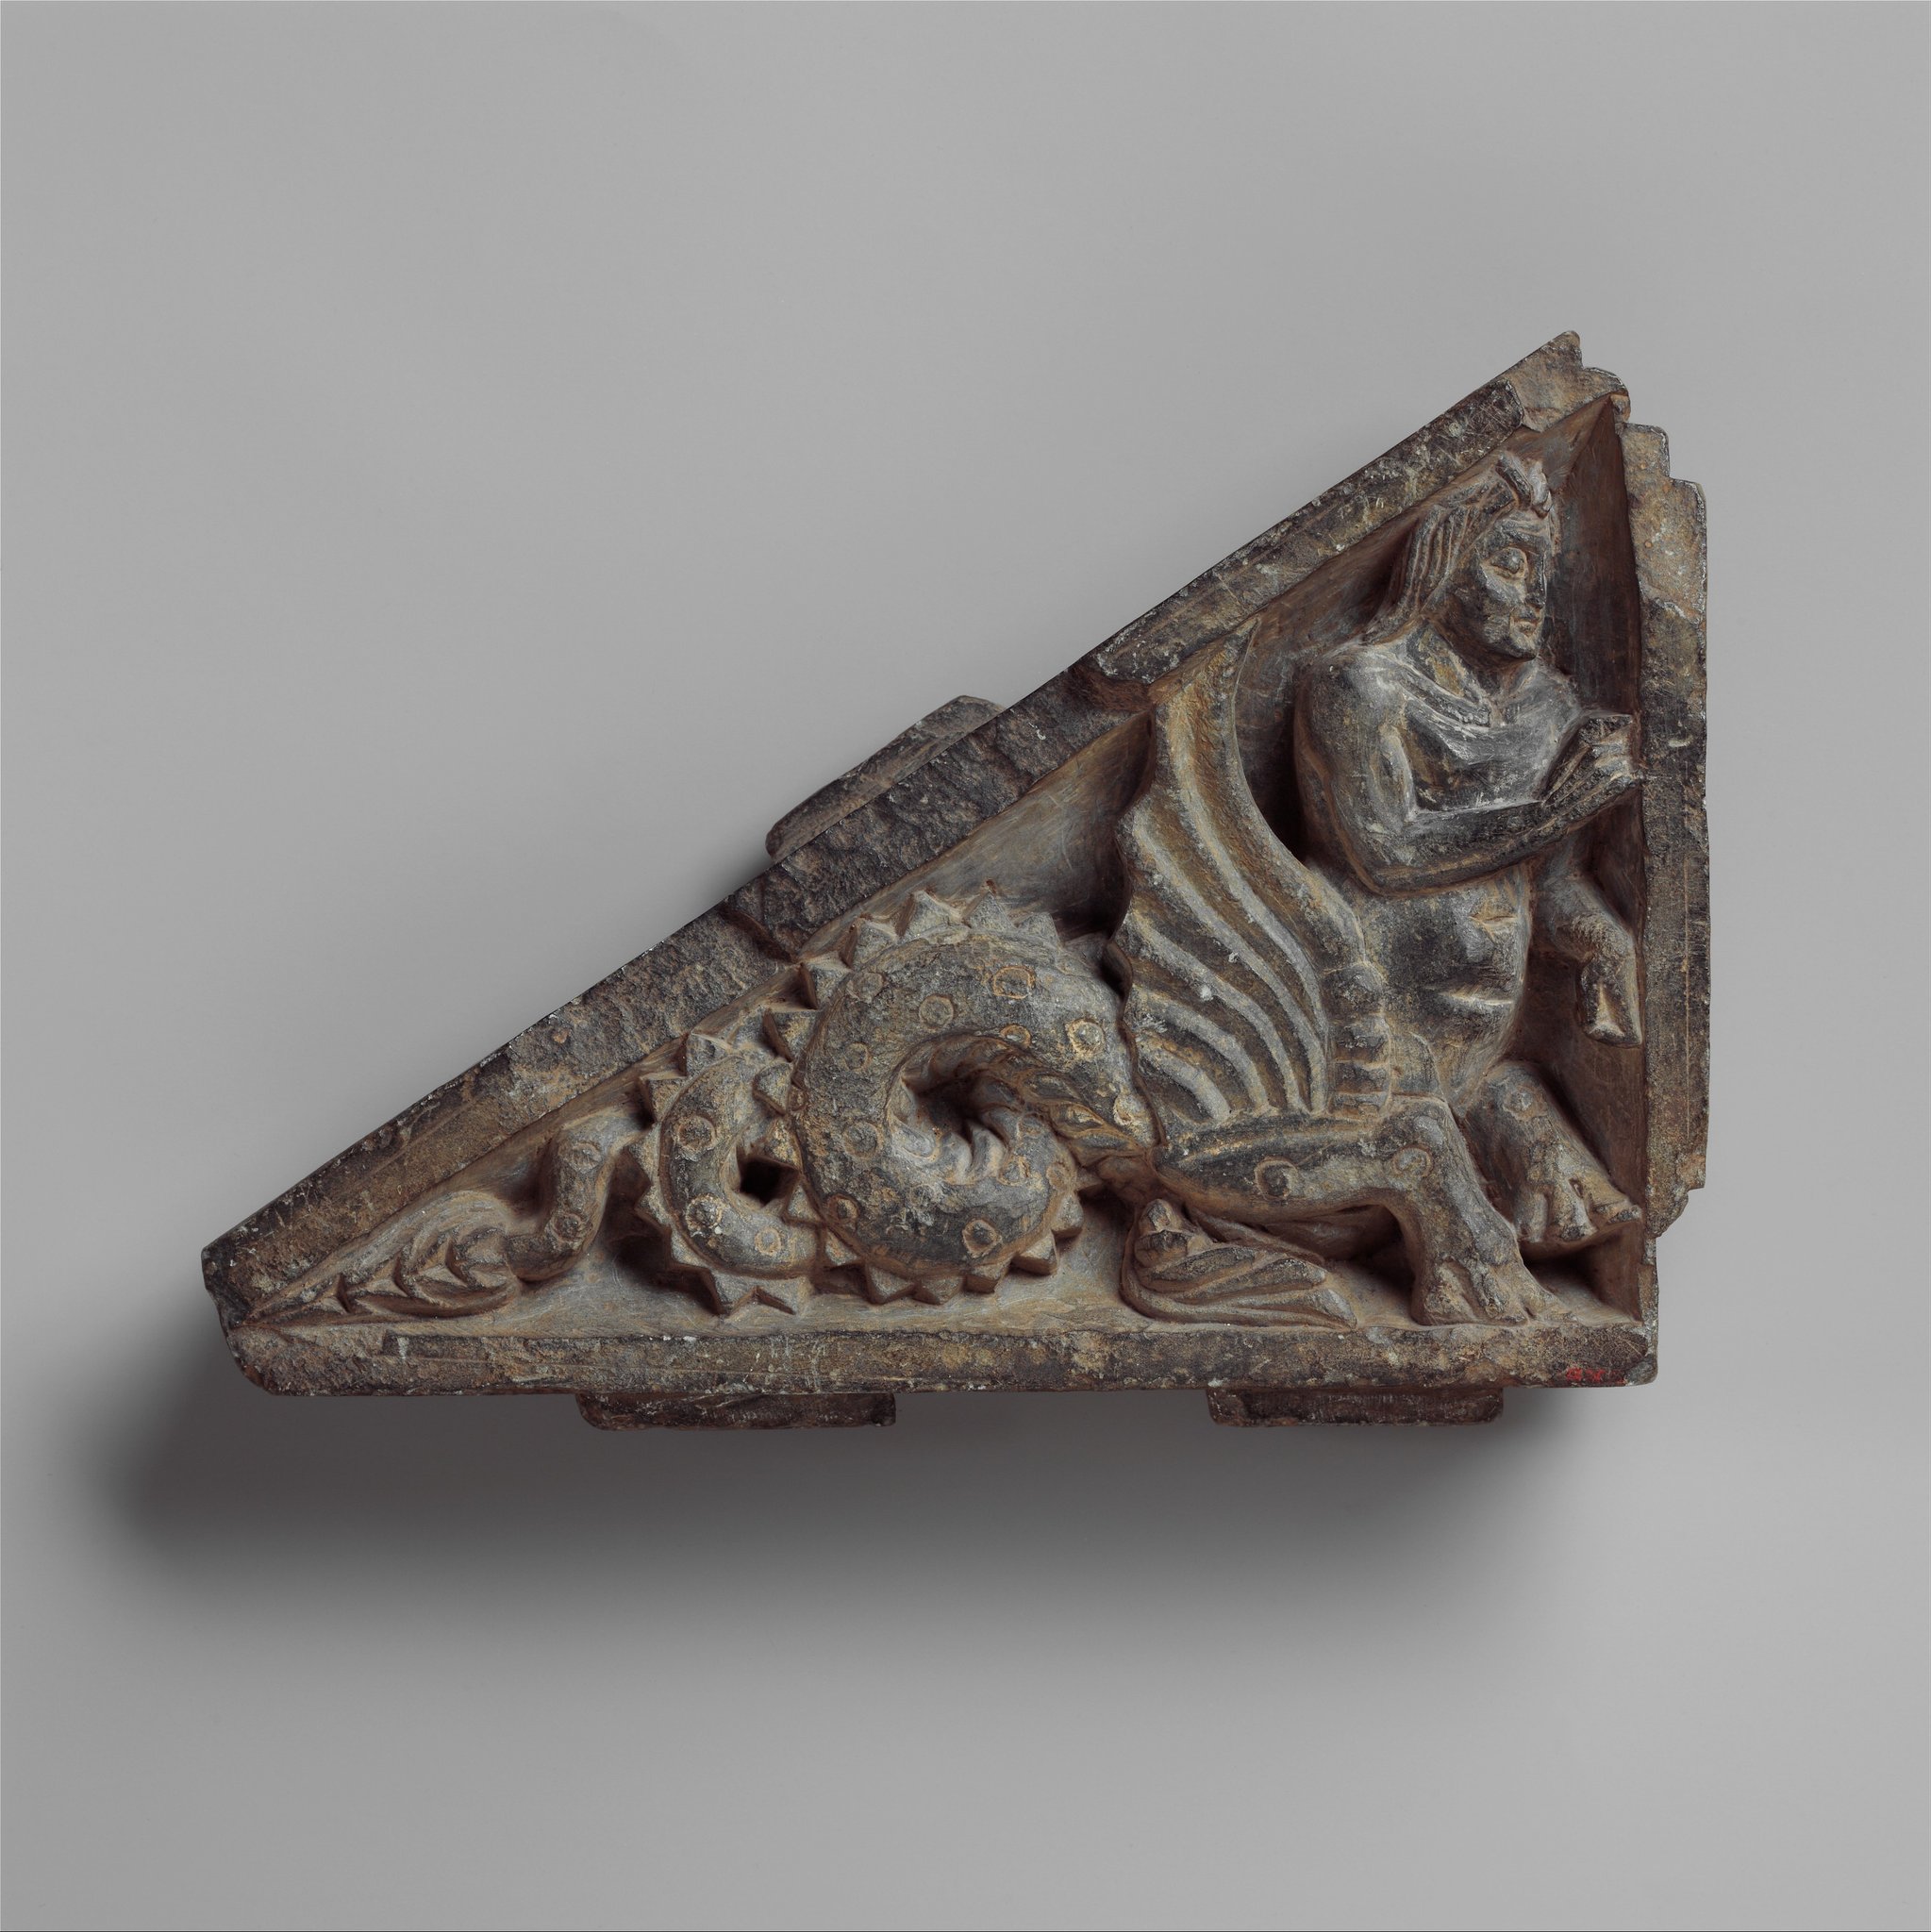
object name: relief panel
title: Marine Deity (Triton or Ichthyocentaur)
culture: pakistani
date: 1-100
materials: stone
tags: gandhara